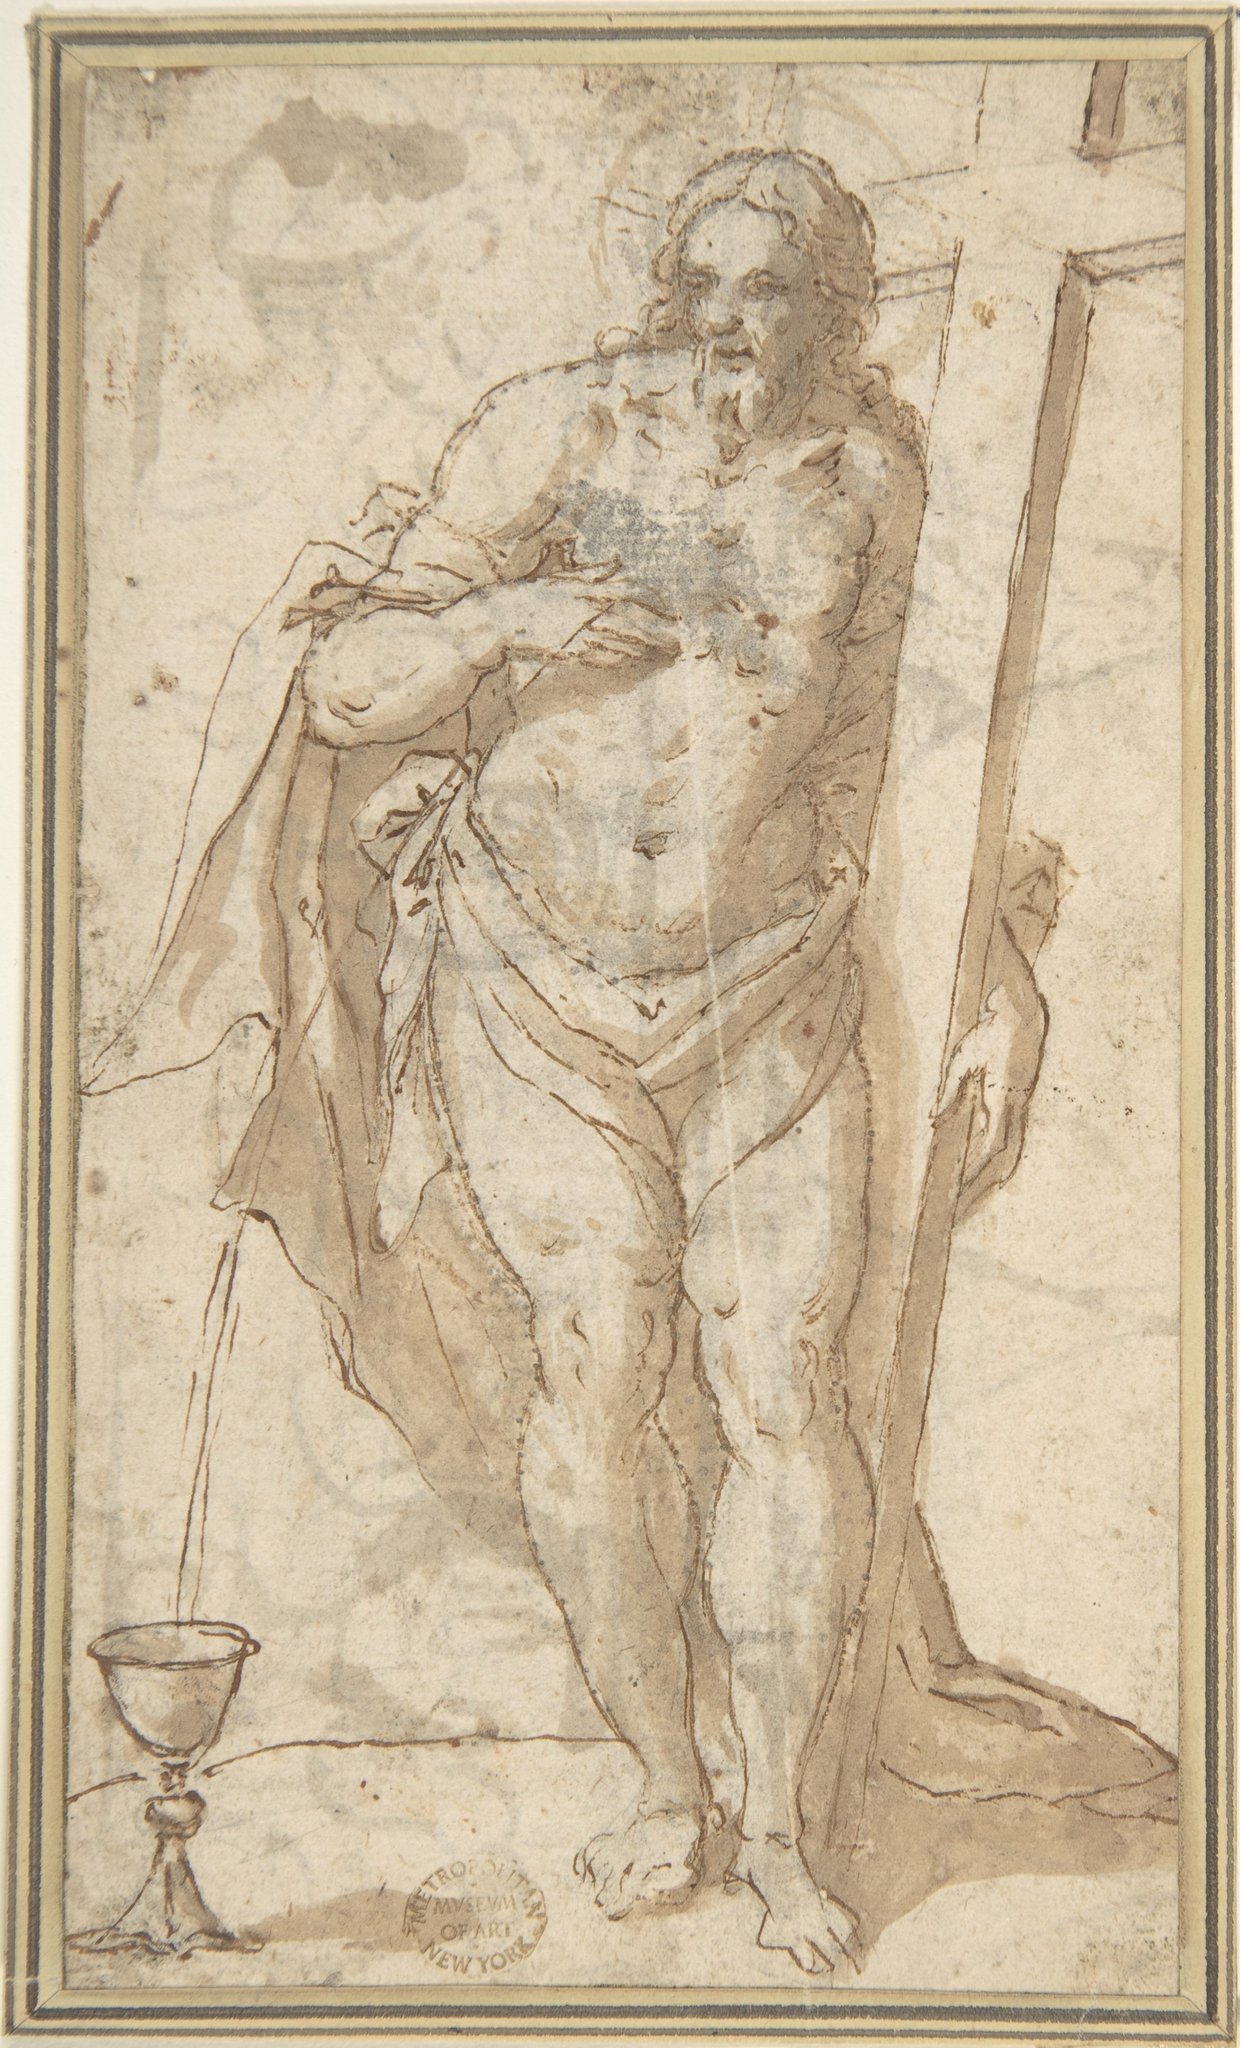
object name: drawing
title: Figure of Christ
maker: anonymous, italian, bolognese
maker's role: artist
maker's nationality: italian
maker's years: 1400-1999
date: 1501-1600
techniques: pen, wash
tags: christ,cross,chalices